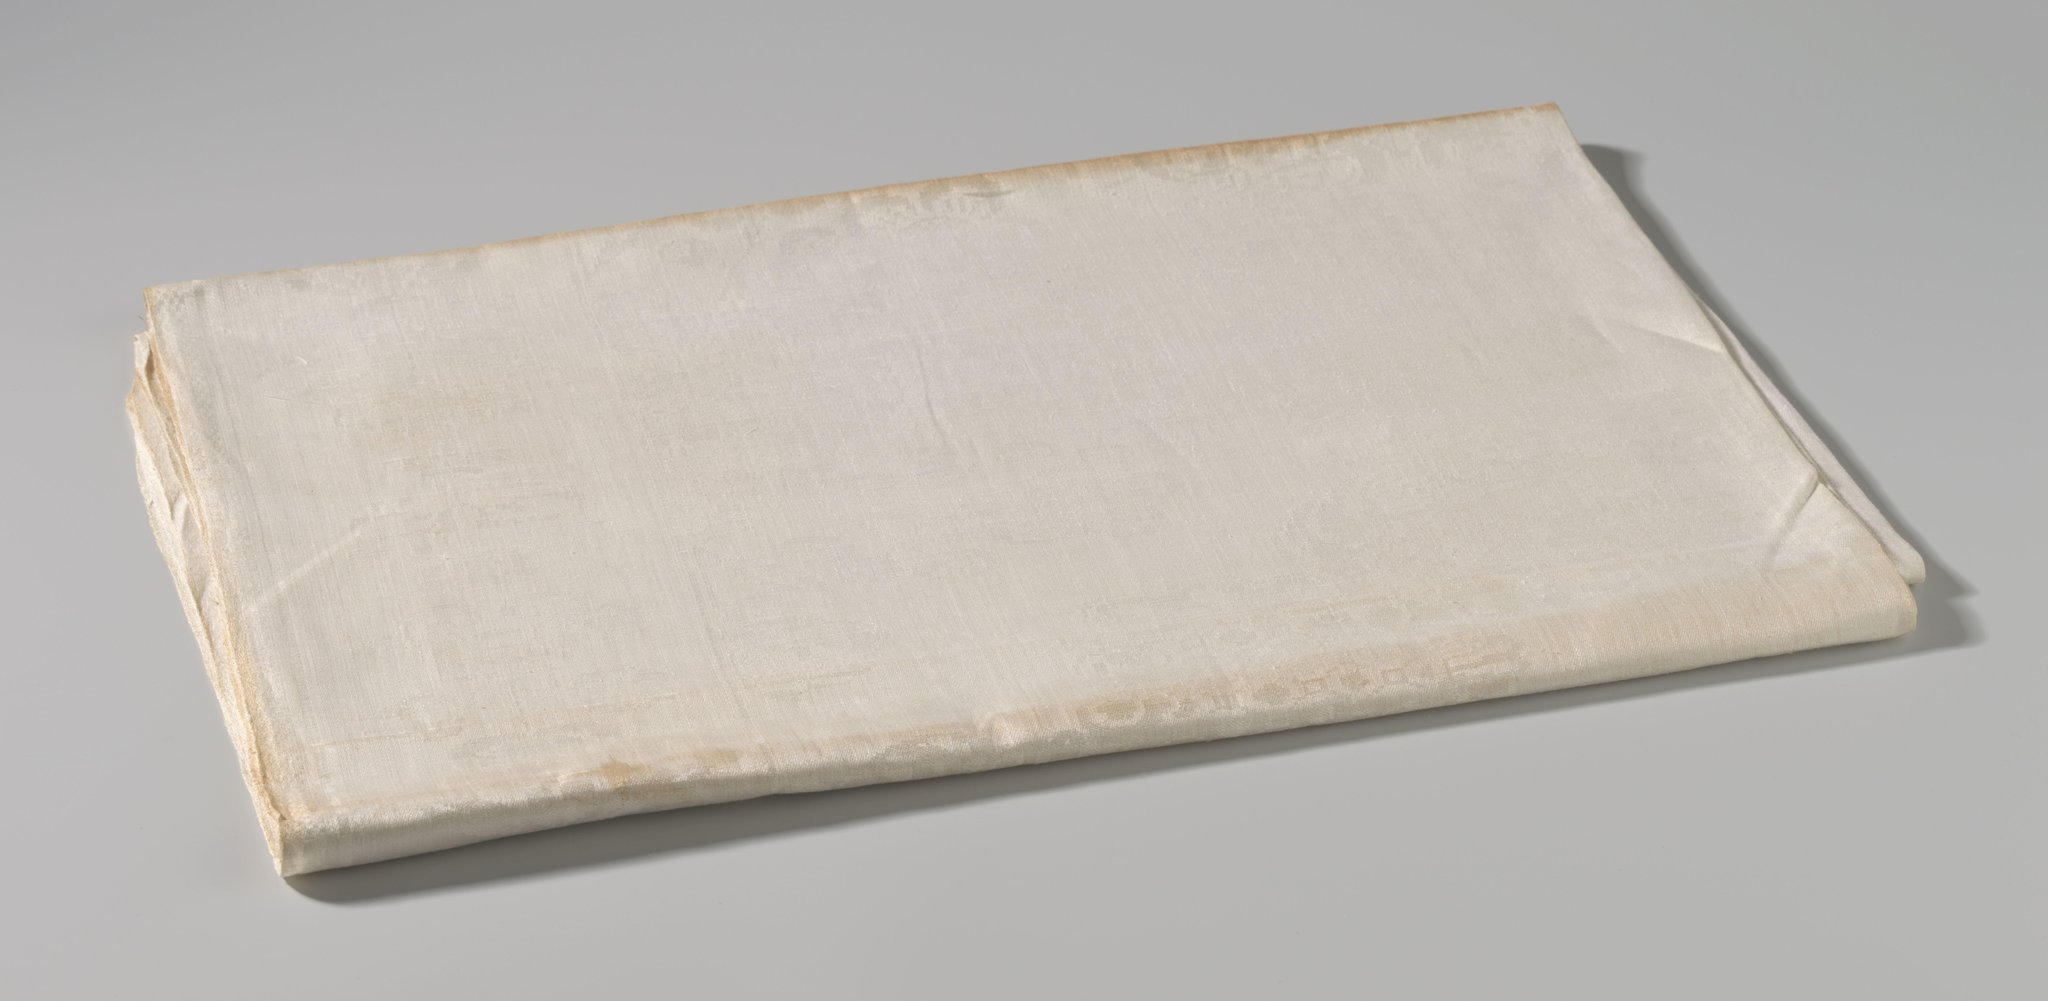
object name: tablecloth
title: Kantpatroon. Merk: kroon G1 en jaartal 1764.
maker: Anonymous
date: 1764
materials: linen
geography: northern netherlands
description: Tafellaken van wit linnen met kantpatroon, merk kroon G 1 1764